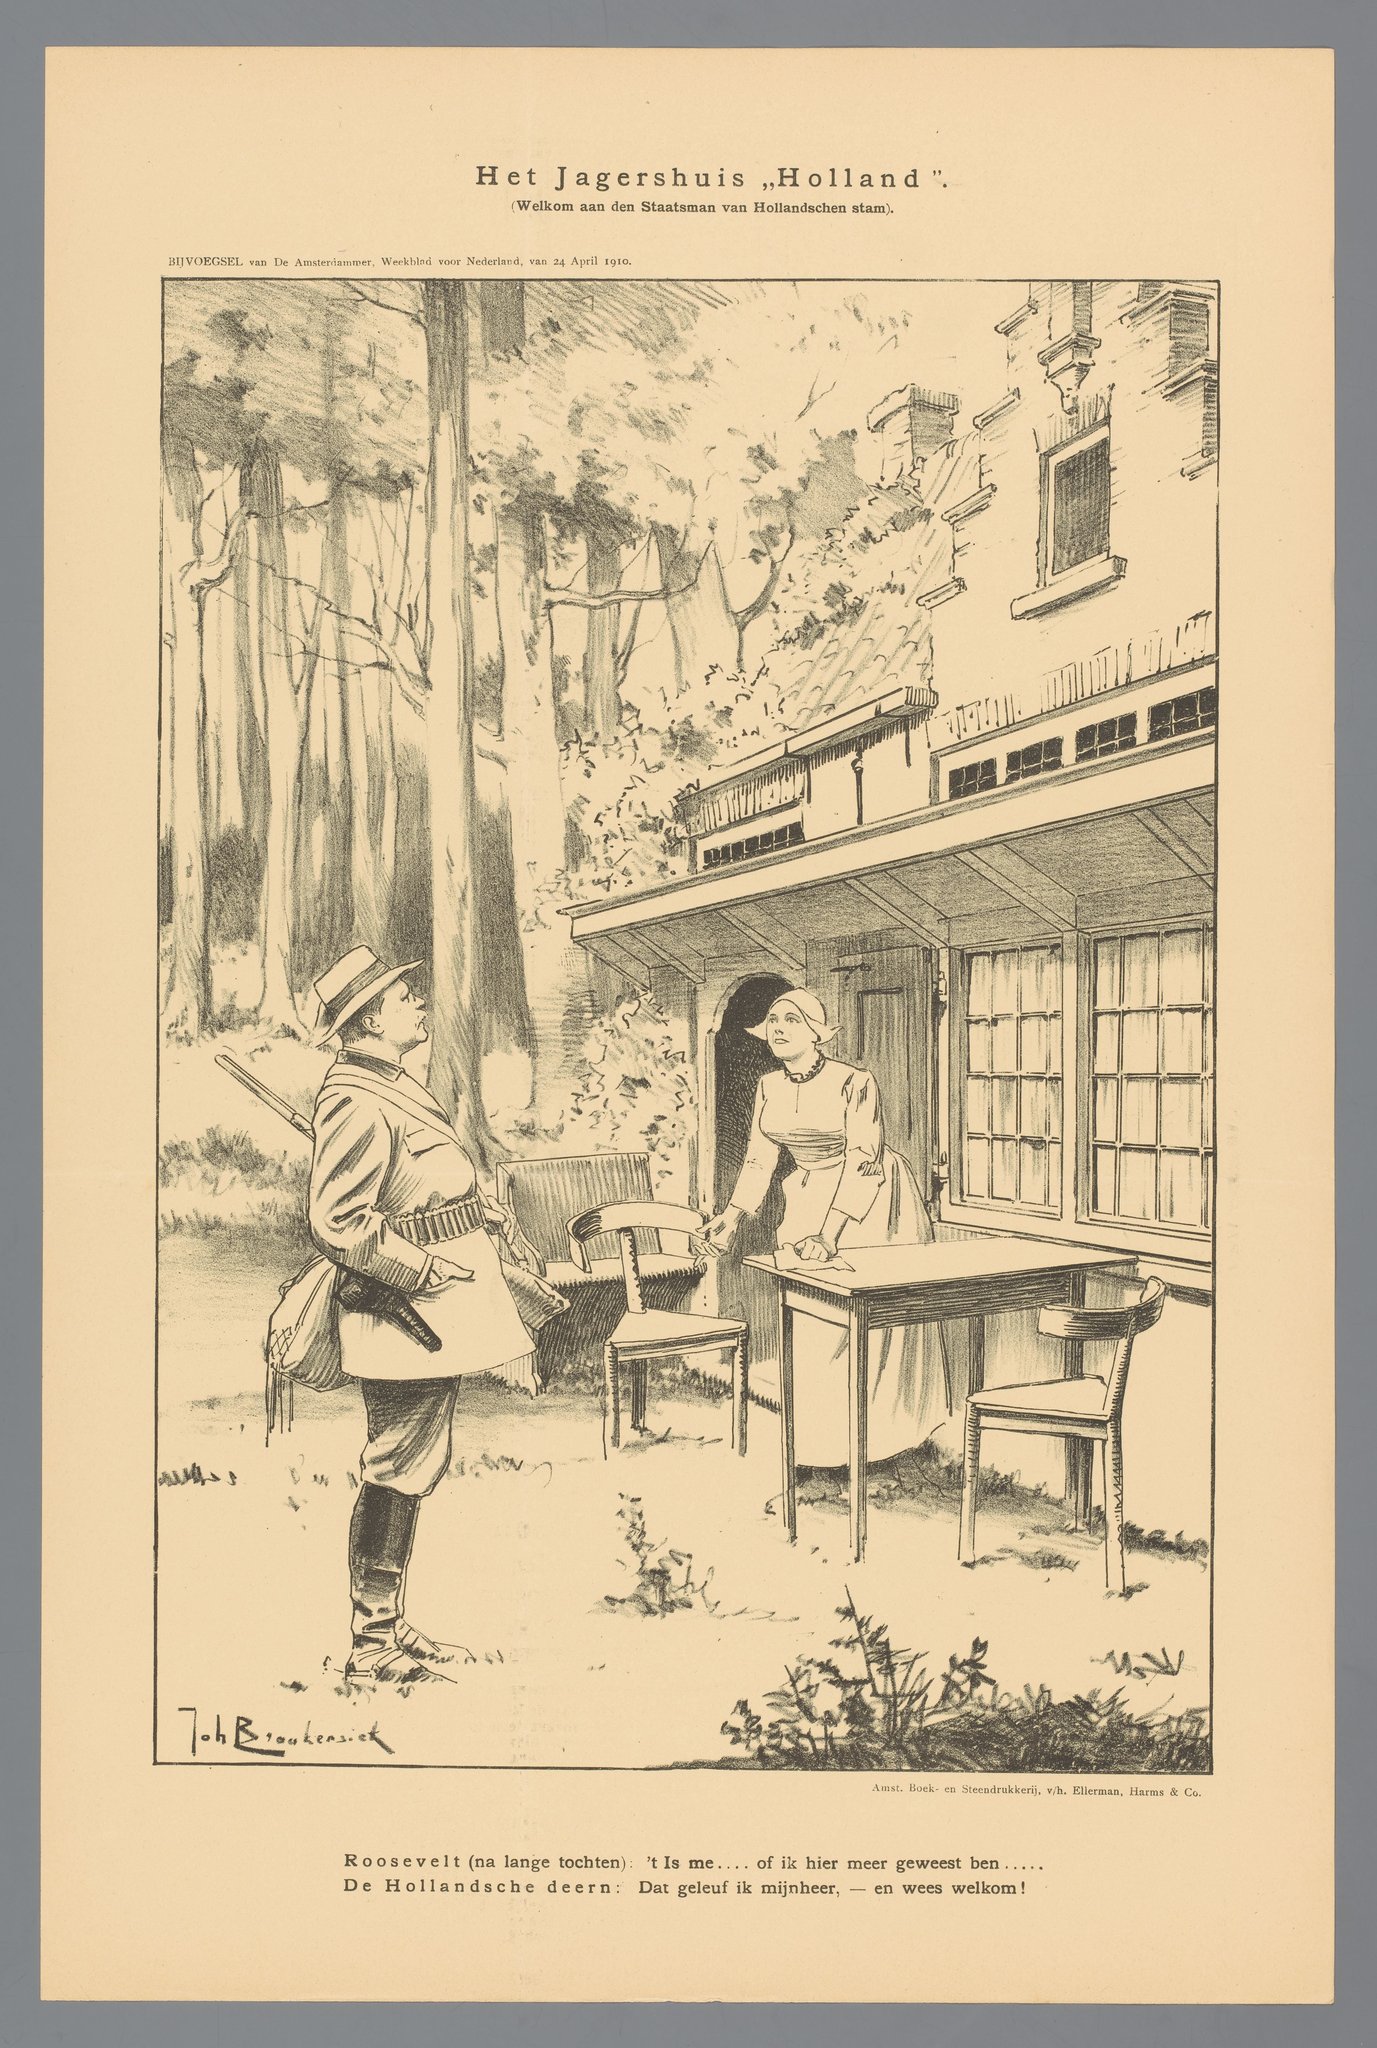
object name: cartoon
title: Het Jagershuis "Holland"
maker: johan braakensiek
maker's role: draughtsman, print maker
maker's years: 1858-1940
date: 1910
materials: paper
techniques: lithograph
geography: amsterdam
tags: president ~ head of republic, historical persons, personifications of countries, nations, states, districts, etc. (+ nation; national), political caricatures and satires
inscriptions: date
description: Prent uit het bijvoegsel van: De Amsterdammer. Weekblad voor Nederland, 24 april 1910.